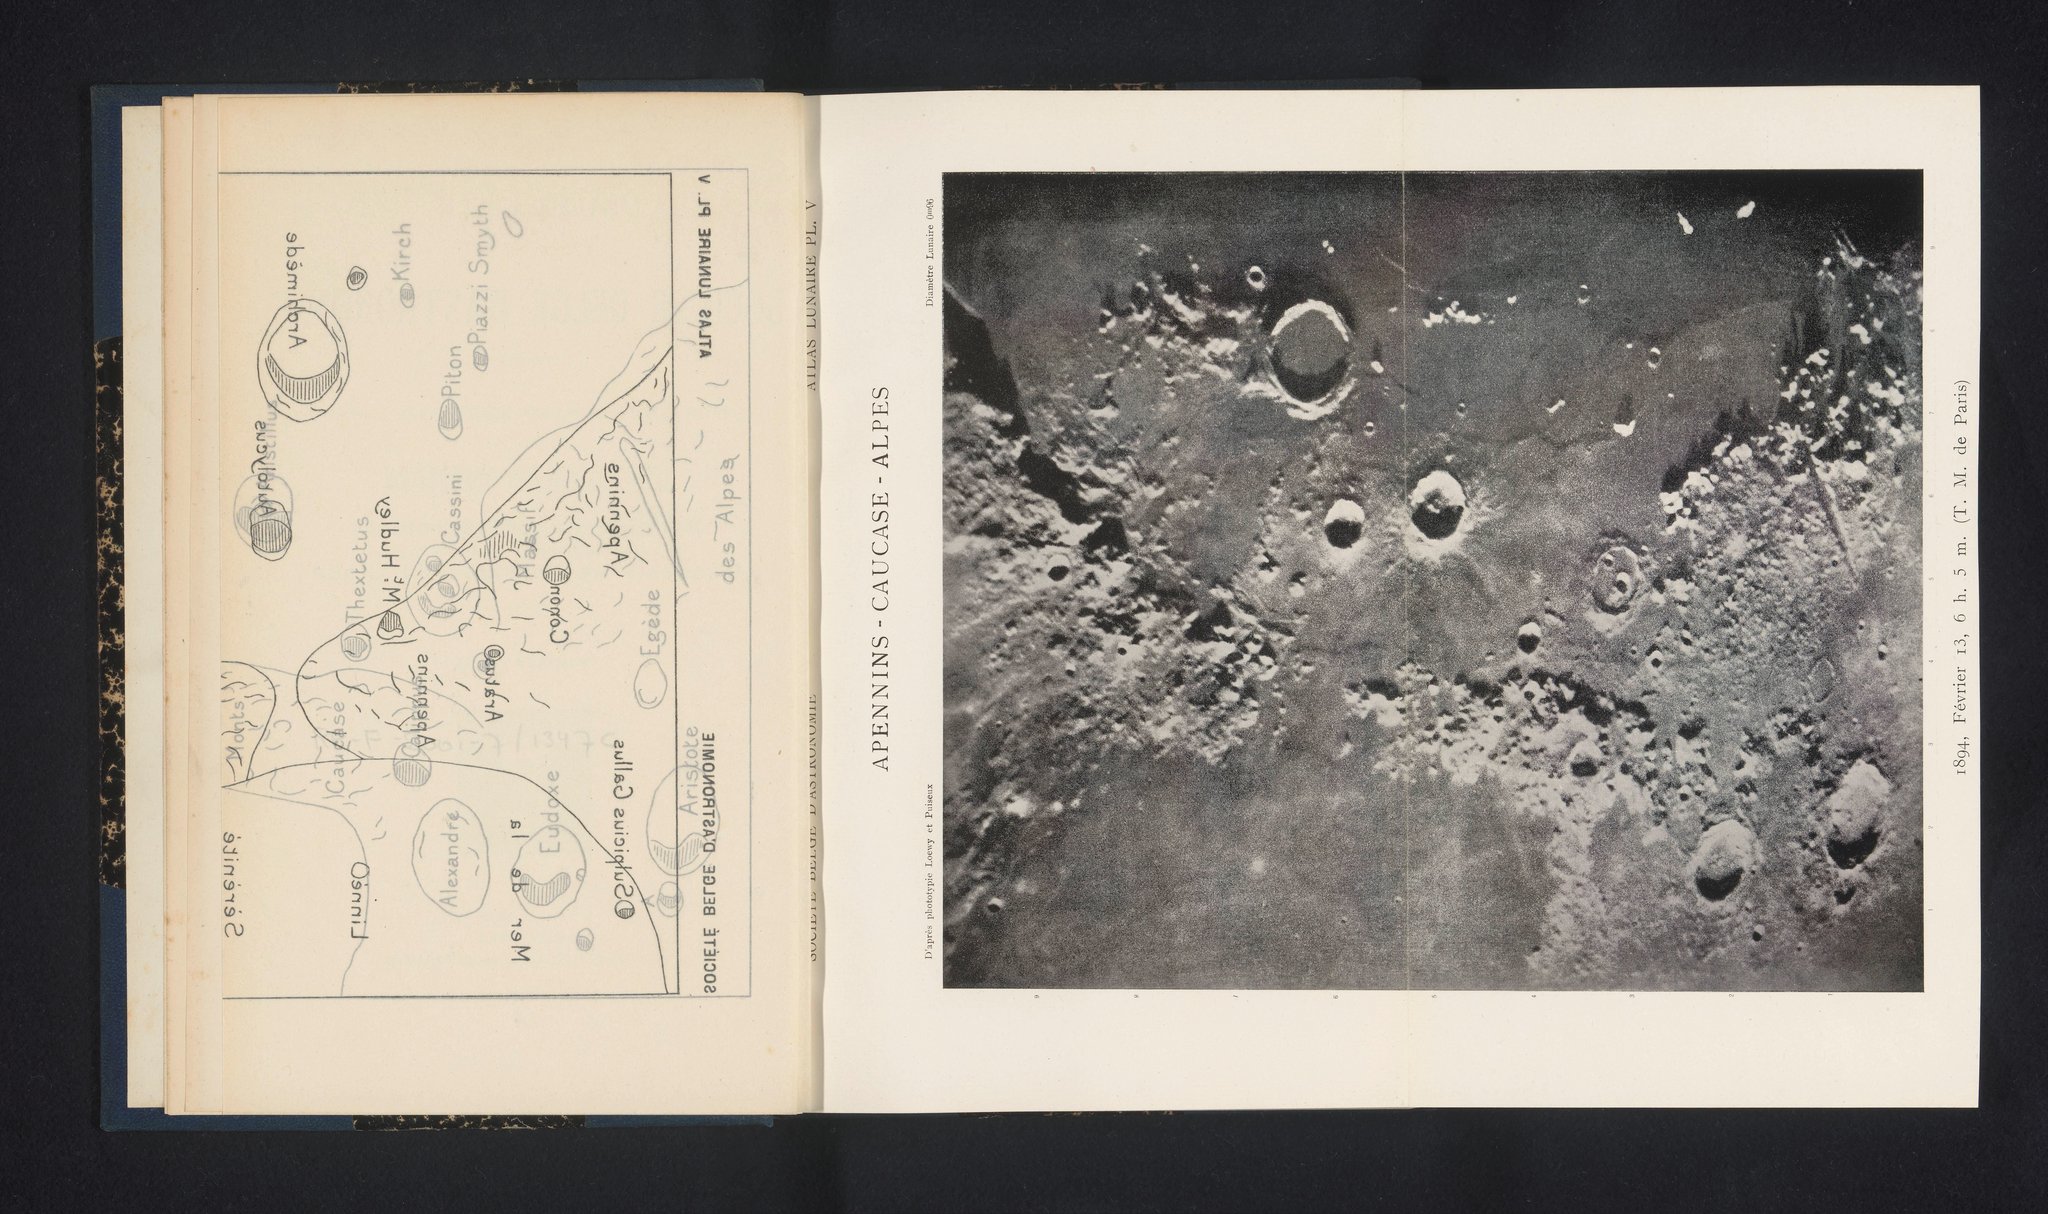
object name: photomechanical print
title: Kraters op de maan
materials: paper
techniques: autotype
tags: surface of the moon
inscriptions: inscription: ‘Société Belge d'Astronomie Atlas Lunaire Pl V./ 1894, Février 13, 6h. 5m. (T. M. de Paris)’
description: Transparante pagina voor prent met daarop de namen van de verschillende kraters.